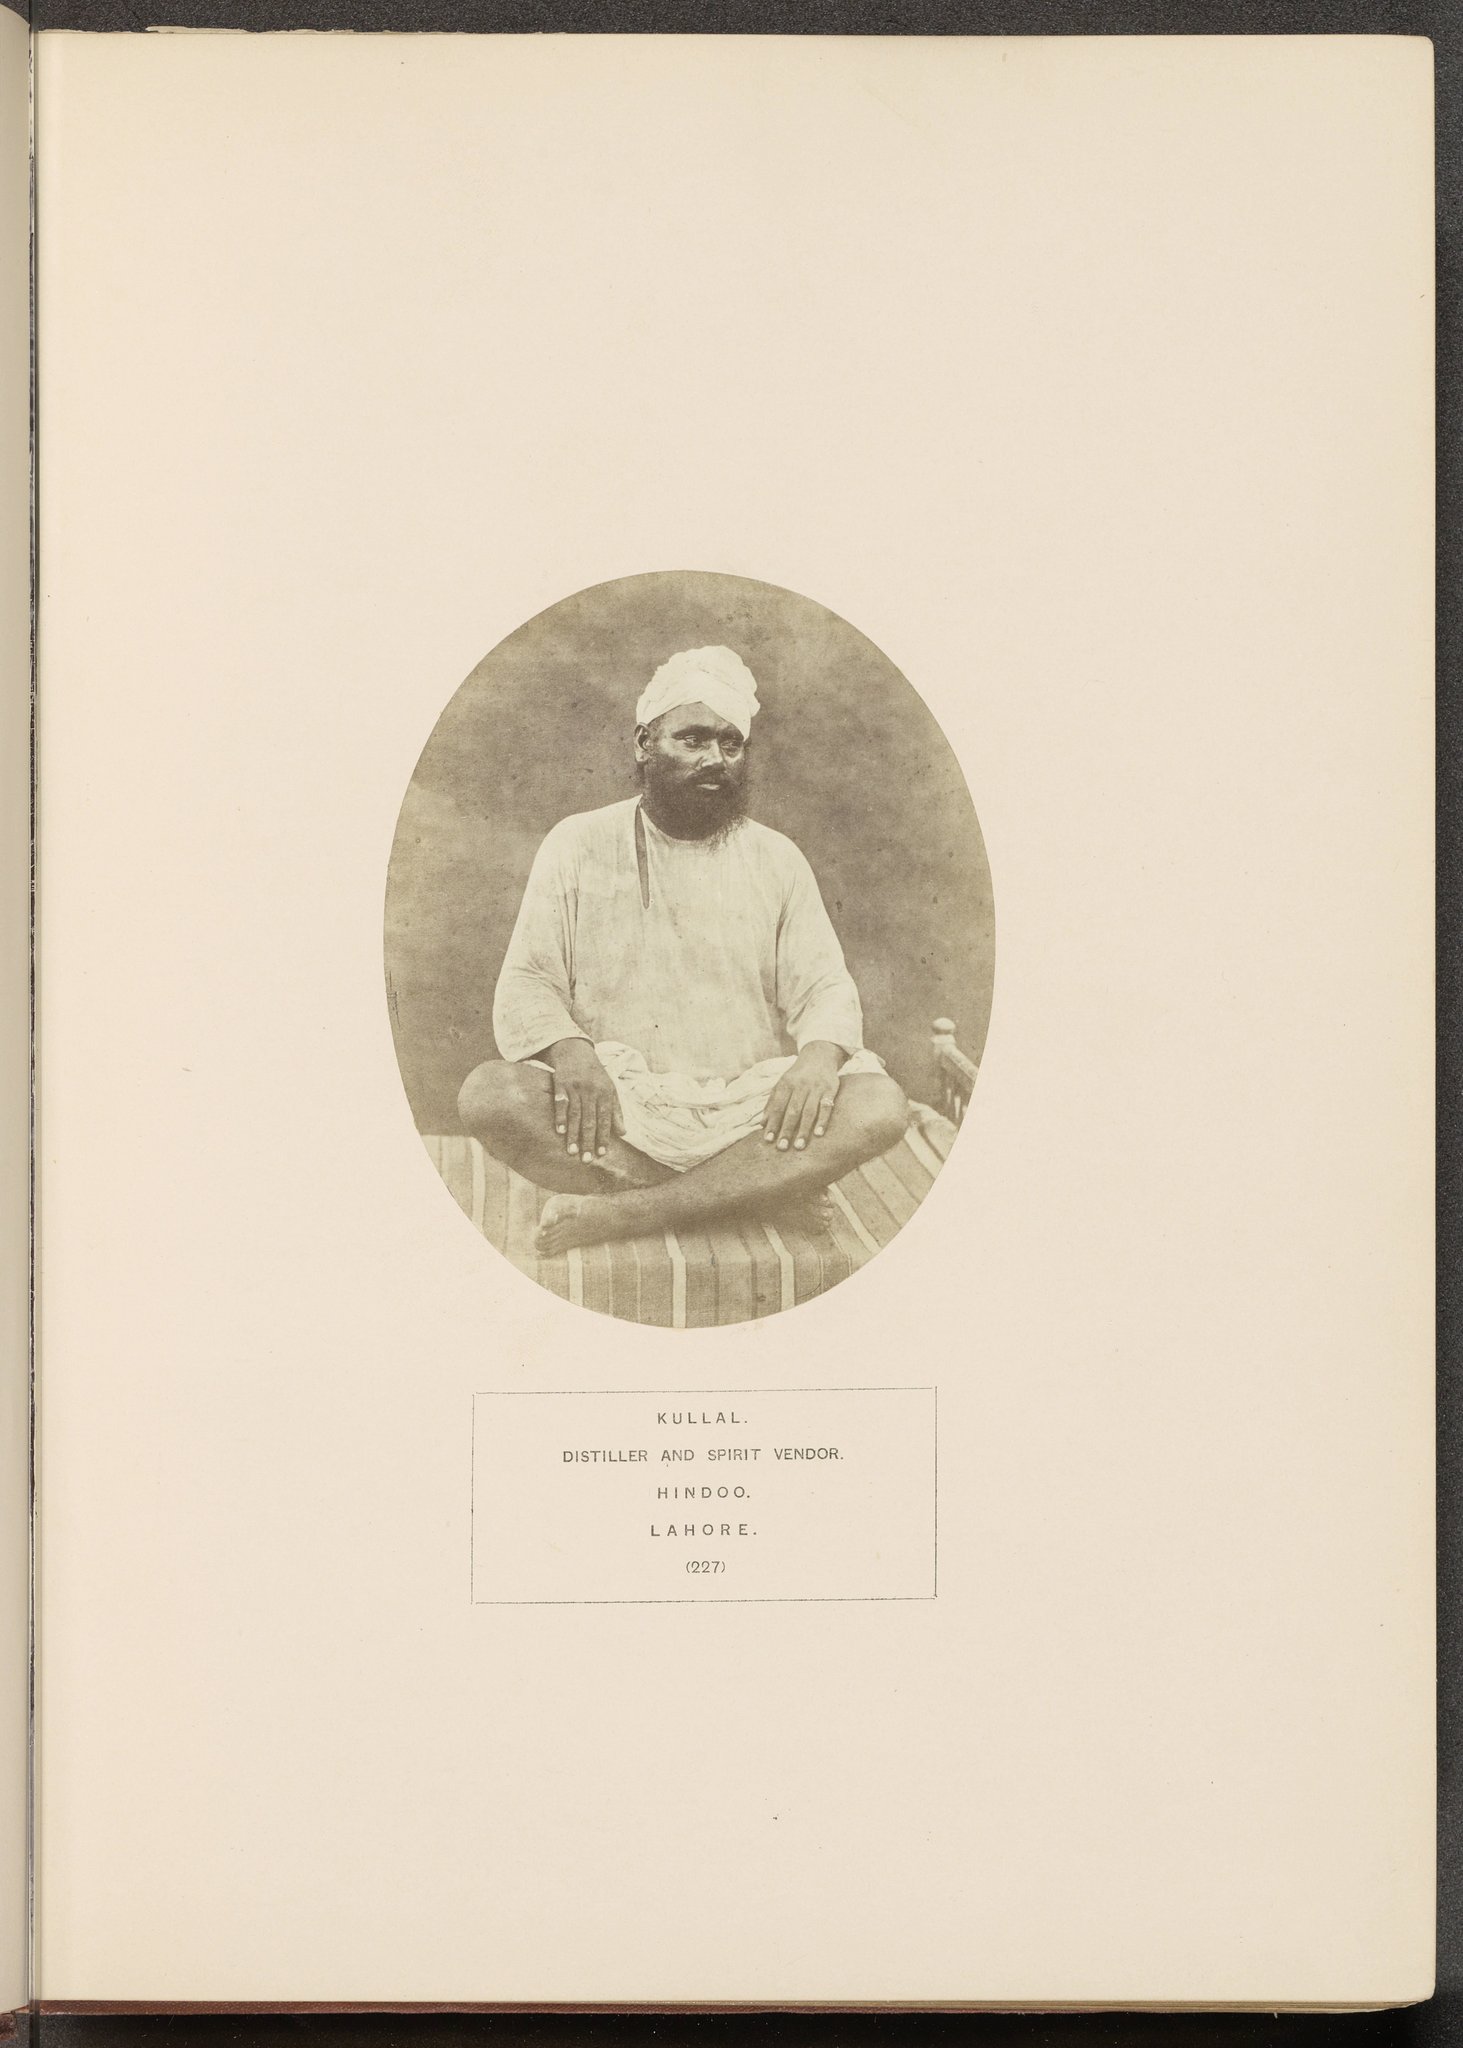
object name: photograph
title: Portrait of a distiller and seller of liquor (kullal) from Lahore, Punjab, Pakistan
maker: Anonymous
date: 1862-1872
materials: photographic support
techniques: albumen print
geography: lahore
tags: human races; peoples; nationalities, distilled spirits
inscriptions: number: ‘(227)’, inscription: ‘KULLAL./ DISTILLER AND SPIRIT VENDOR./ HINDOO./ LAHORE.’